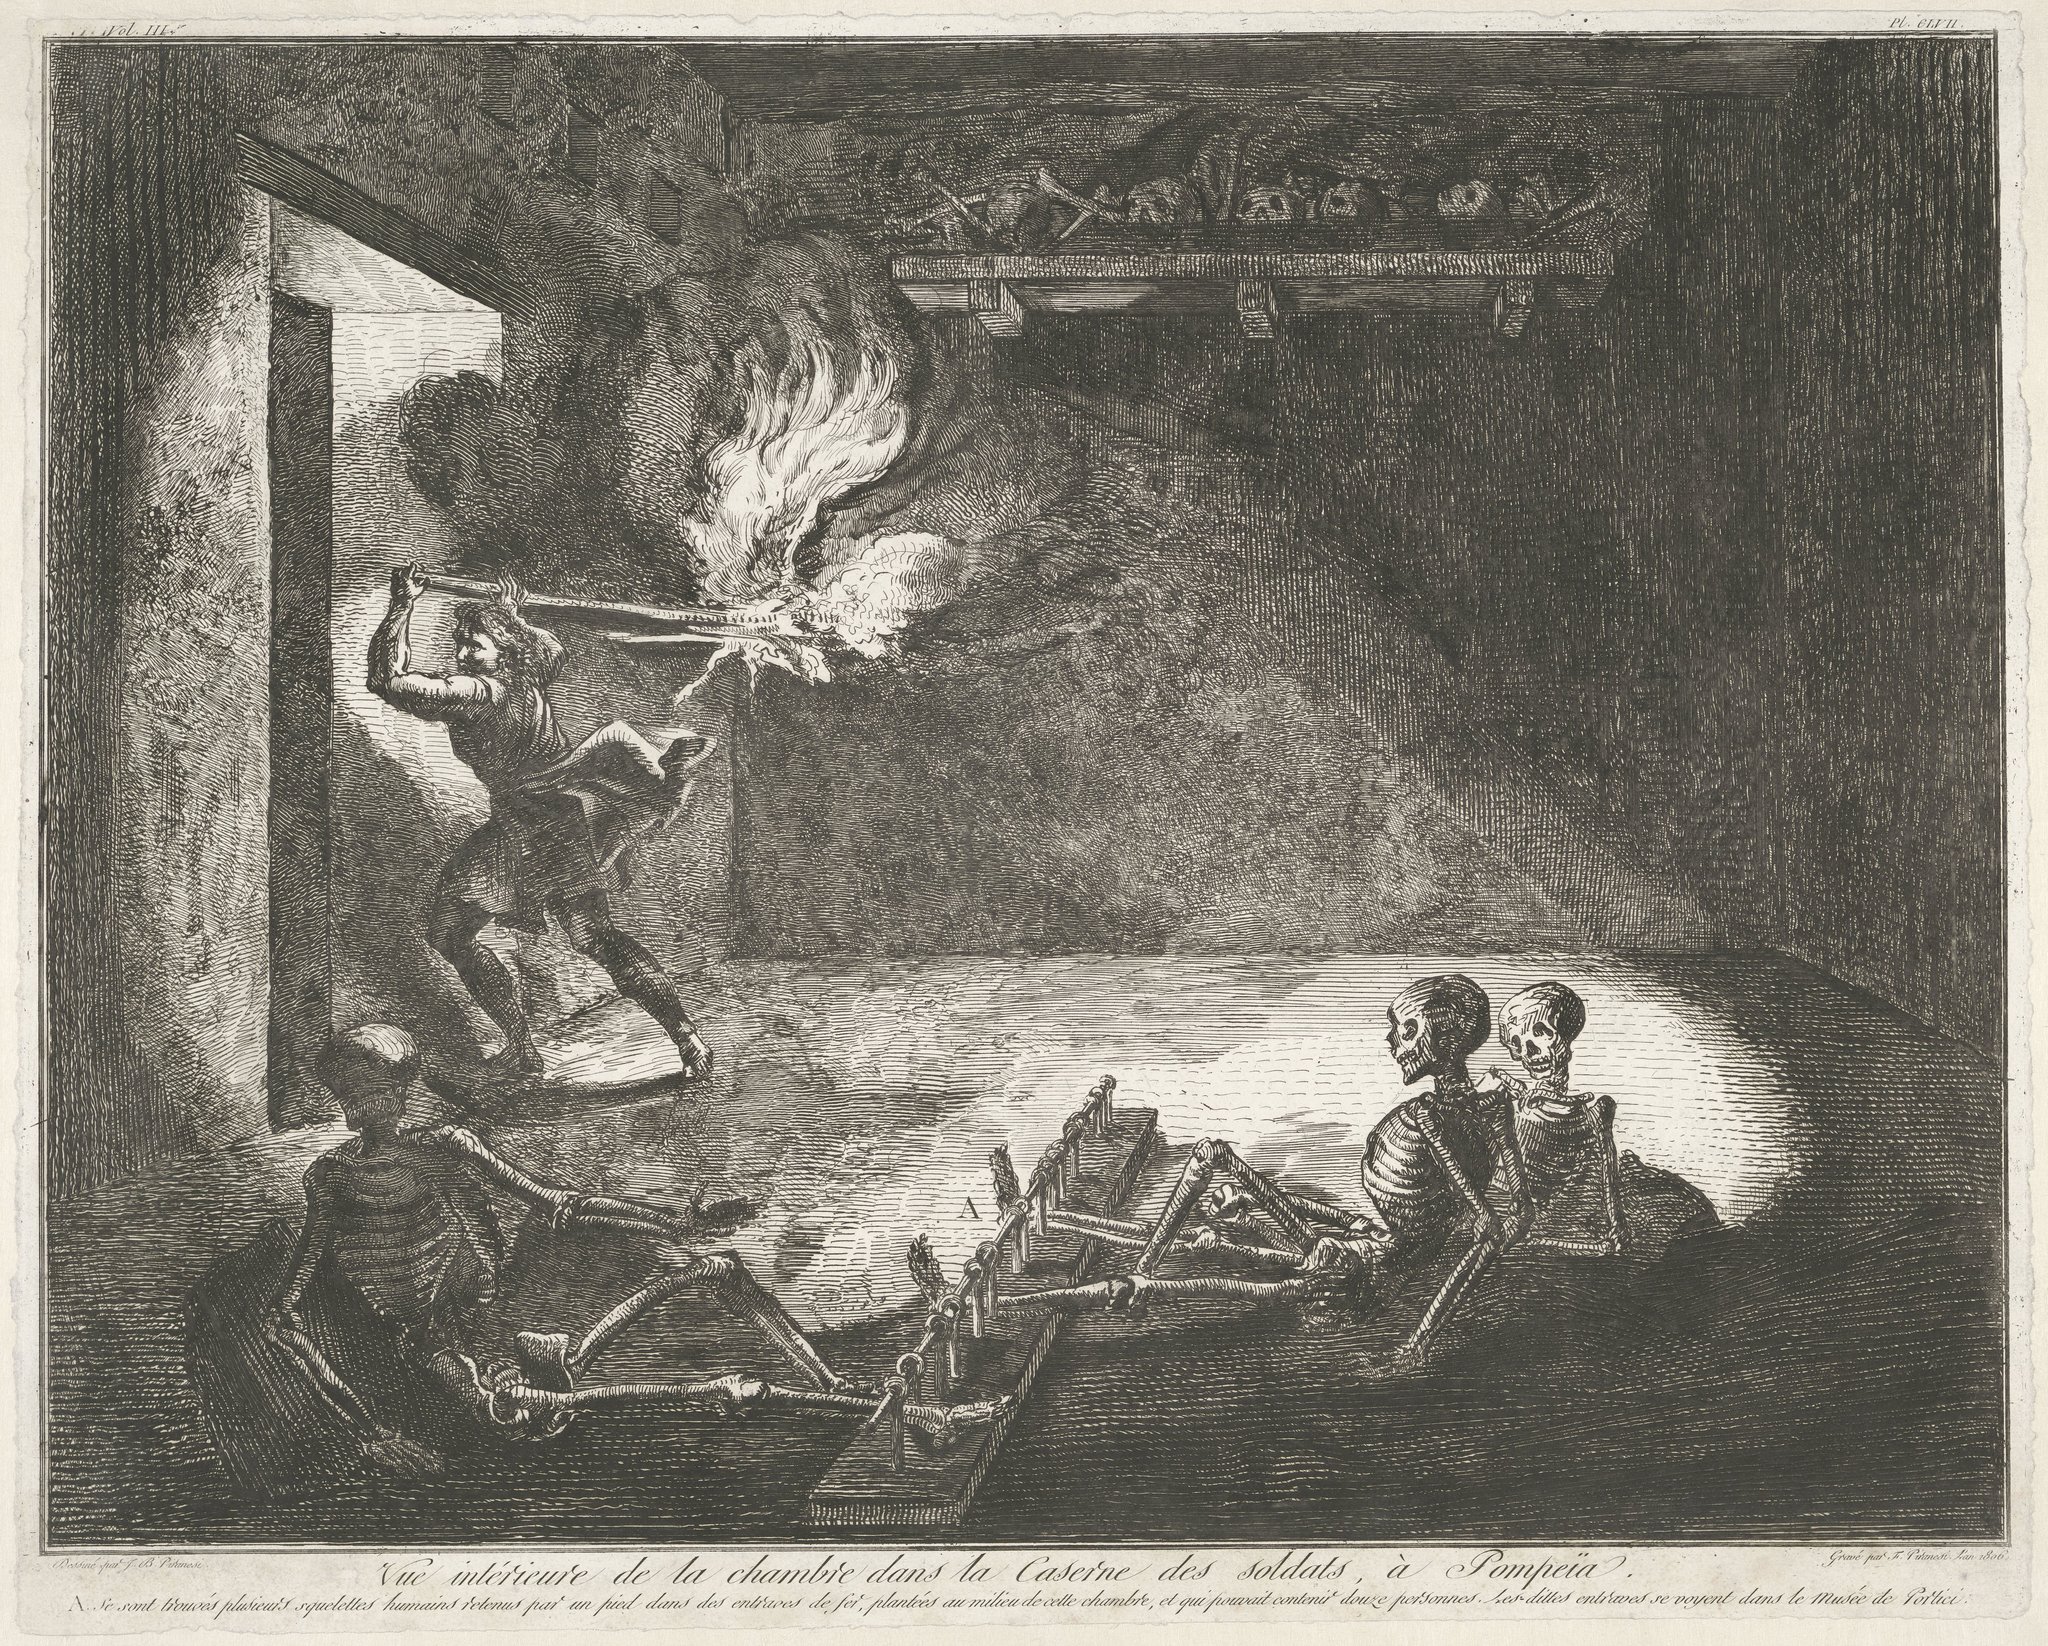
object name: print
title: Antiquités de la Grande Grèce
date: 1806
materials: paper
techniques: etching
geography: italy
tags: torch, (human) skeleton, barracks, pompeii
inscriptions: collector's mark: Lugt 2760, collector's mark: Lugt 2228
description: Gezicht in een soldatenkazerne te Pompeï. Drie skeletten liggen op de voorgrond. Een man met fakkel rent de ruimte uit. Tekst in het Italiaans in ondermarge. Genummerd linksboven: Vol. III., rechtsboven: Pl. CLVII.